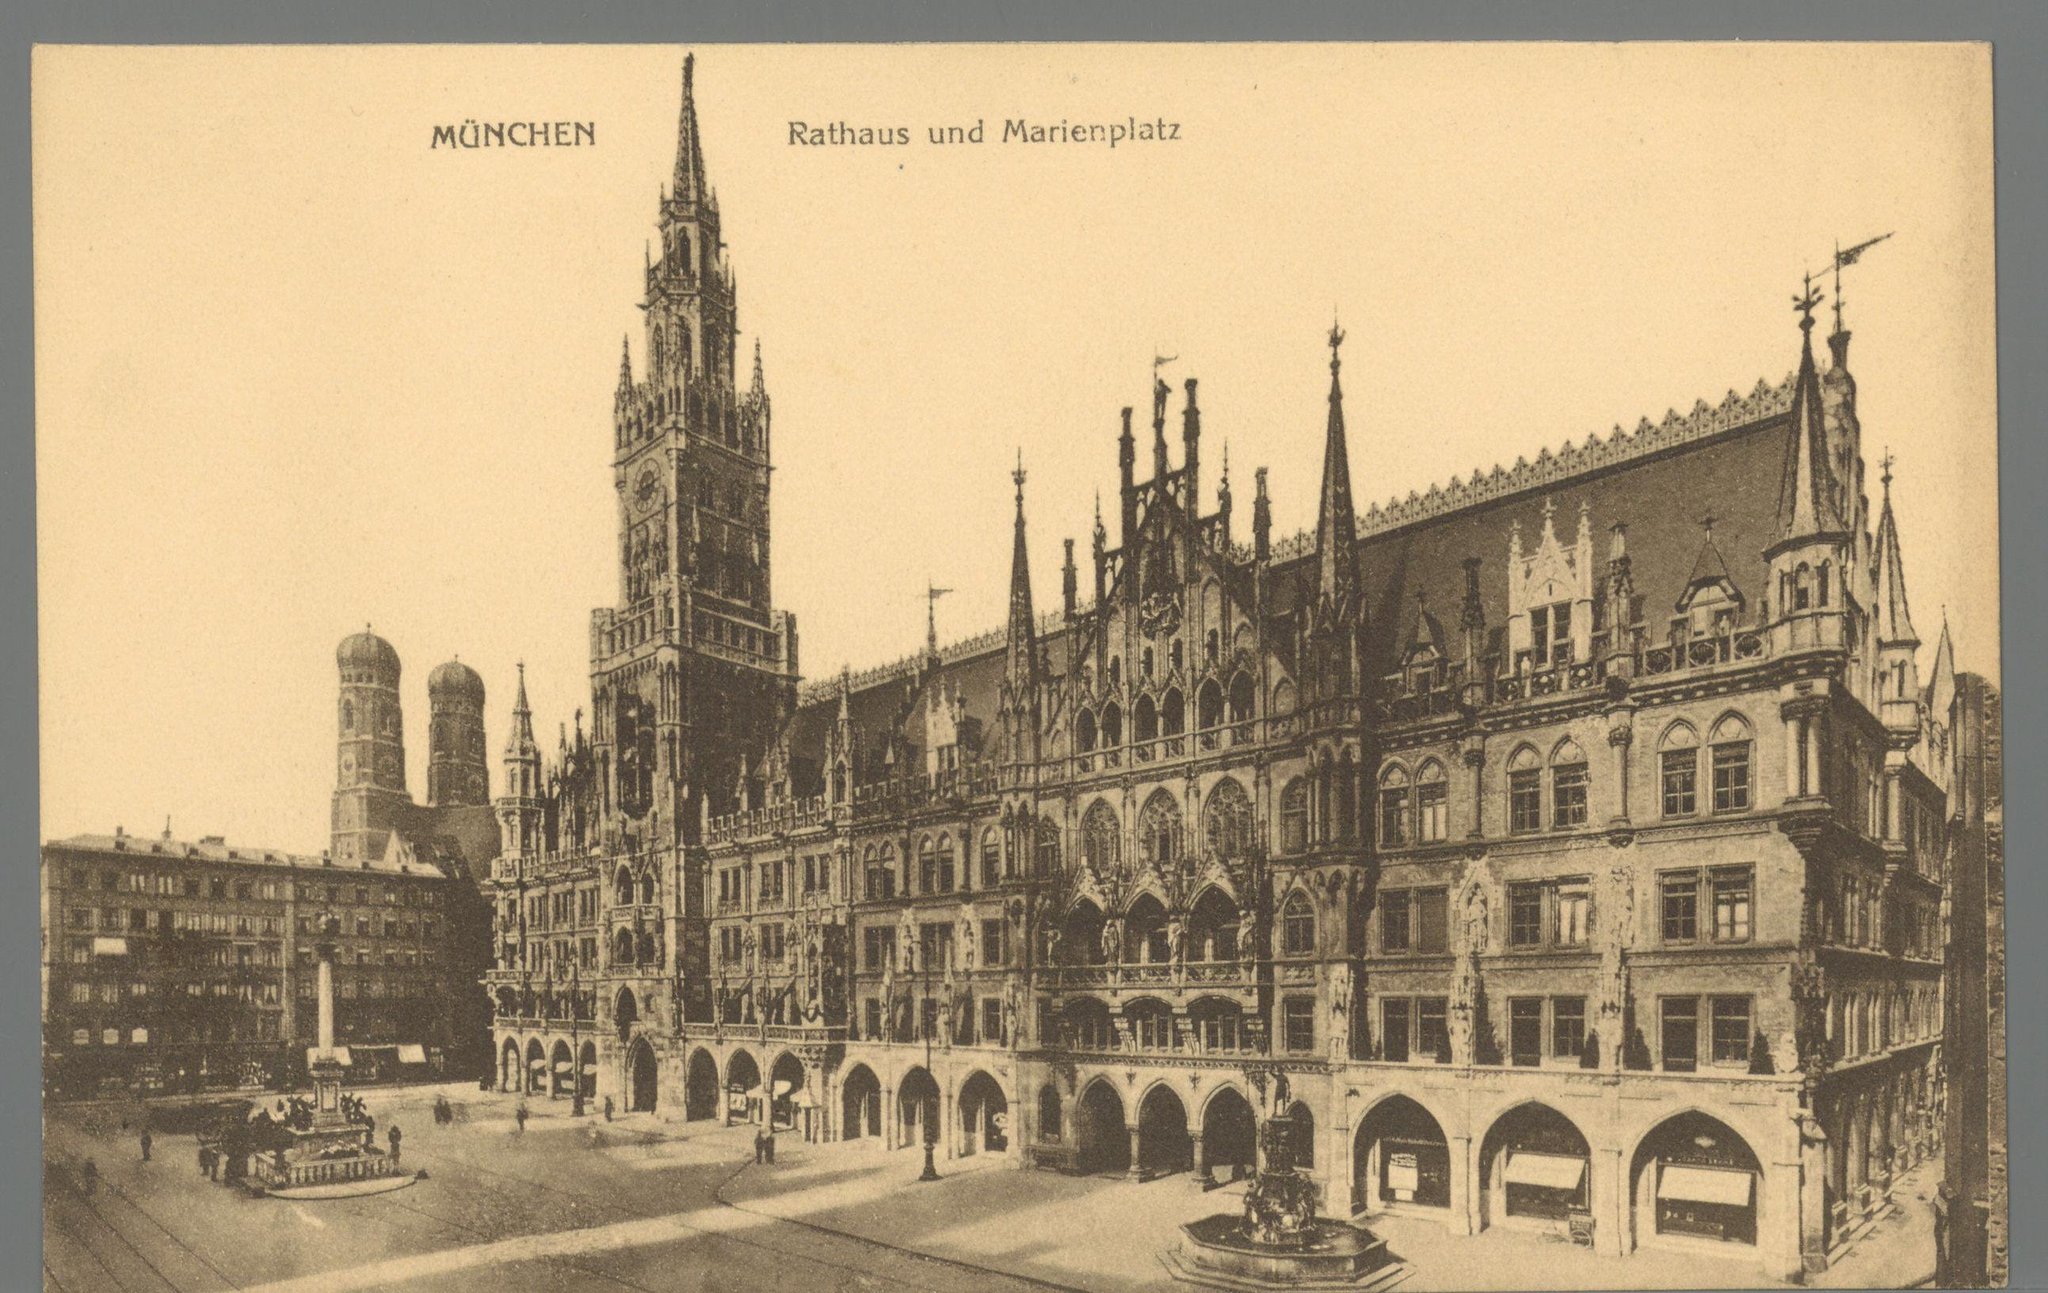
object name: ansichtkaart, prentbriefkaart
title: München. Rathaus und Marienplatz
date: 1905-1930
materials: cardboard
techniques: photograph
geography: munich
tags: square, place, circus, etc., church (exterior), townhall, monument, statue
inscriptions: inscription: ‘W.H.D.’